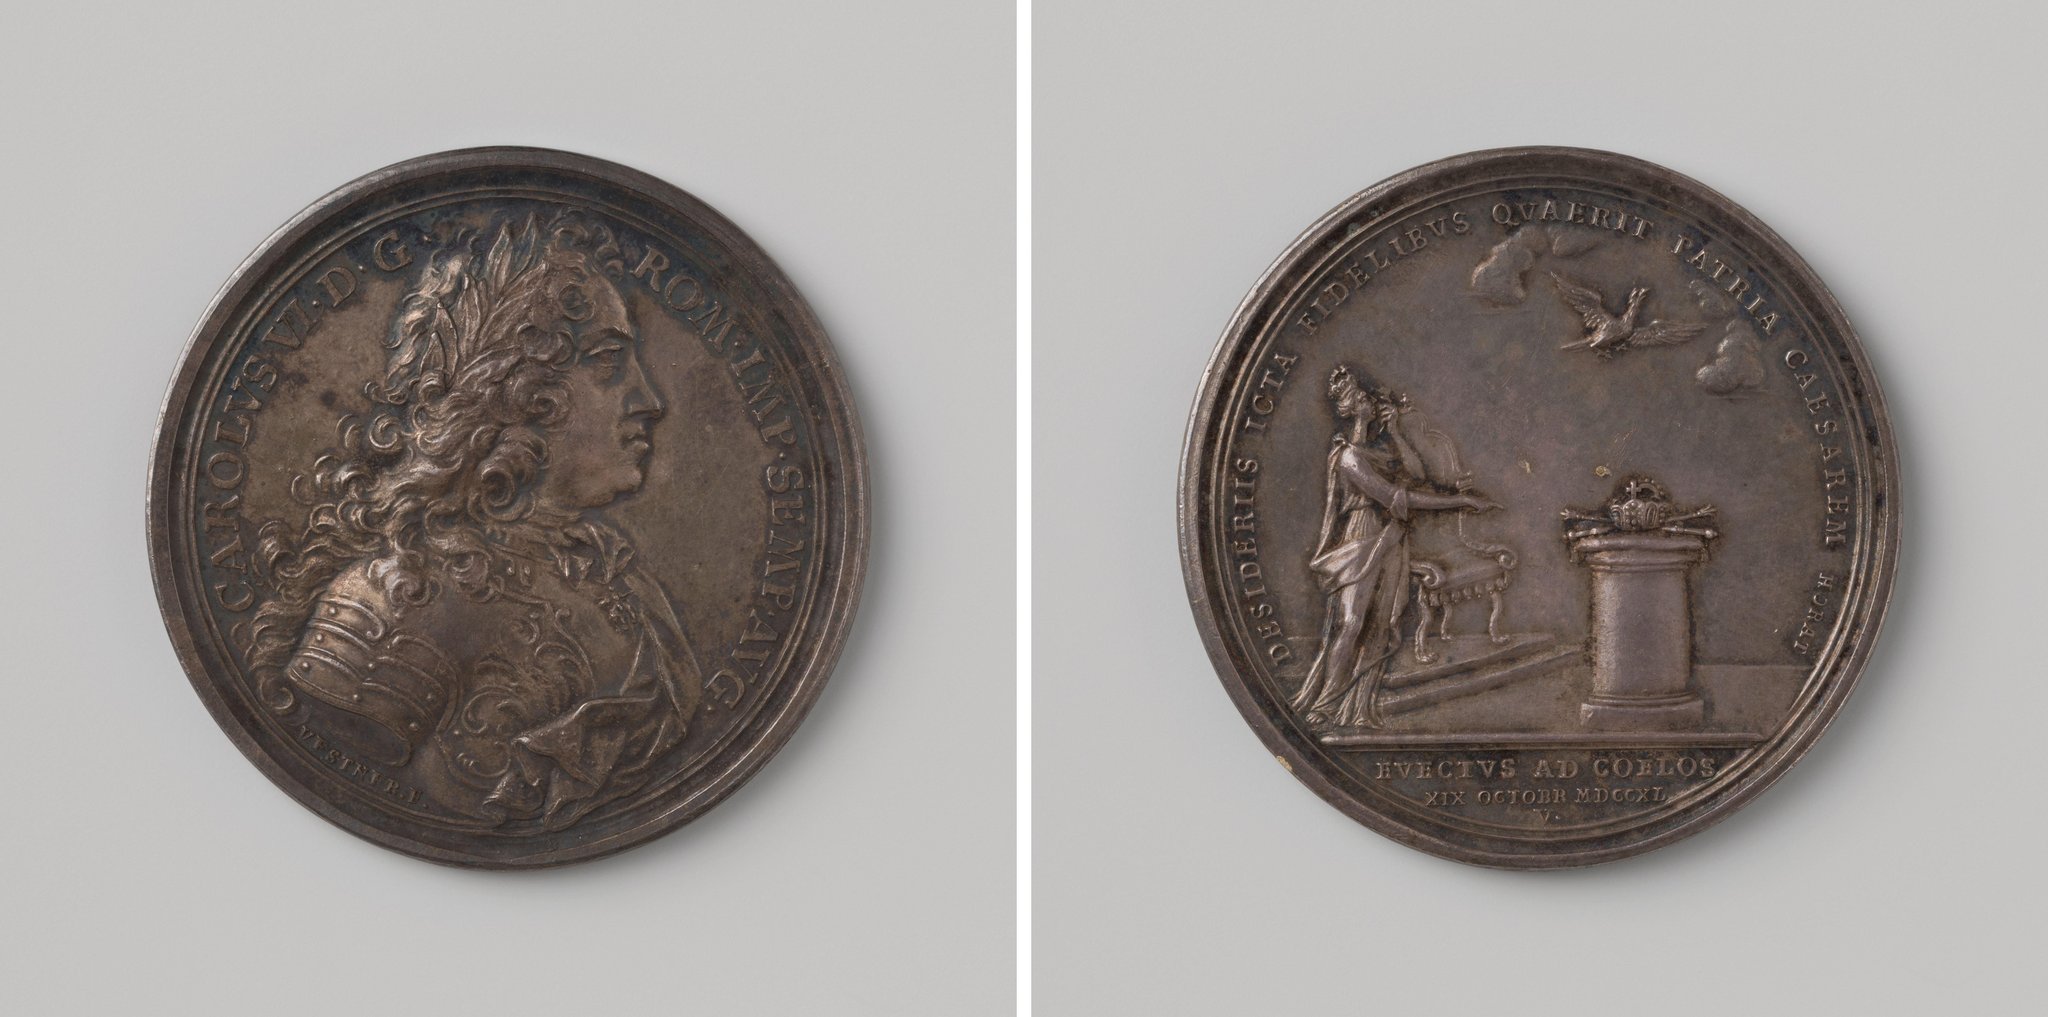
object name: history medal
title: Overlijden van Karel VI, Duits keizer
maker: georg wilhelm vestner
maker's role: medailleur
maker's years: 1677-1740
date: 1740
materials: silver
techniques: striking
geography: nuremberg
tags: vienna, charles vi (holy roman emperor)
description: Zilveren penning. Voorzijde: borststuk man met lauwerkrans binnen omschrift. Keerzijde: Duitsland, in gedaante van gekroonde vrouw, staat wenend bij lege zetel en kijkt arend na, die hemelwaarts richt, naast haar altaar waarop kroon en scepters liggen binnen omschrift; afsnede: opschrift